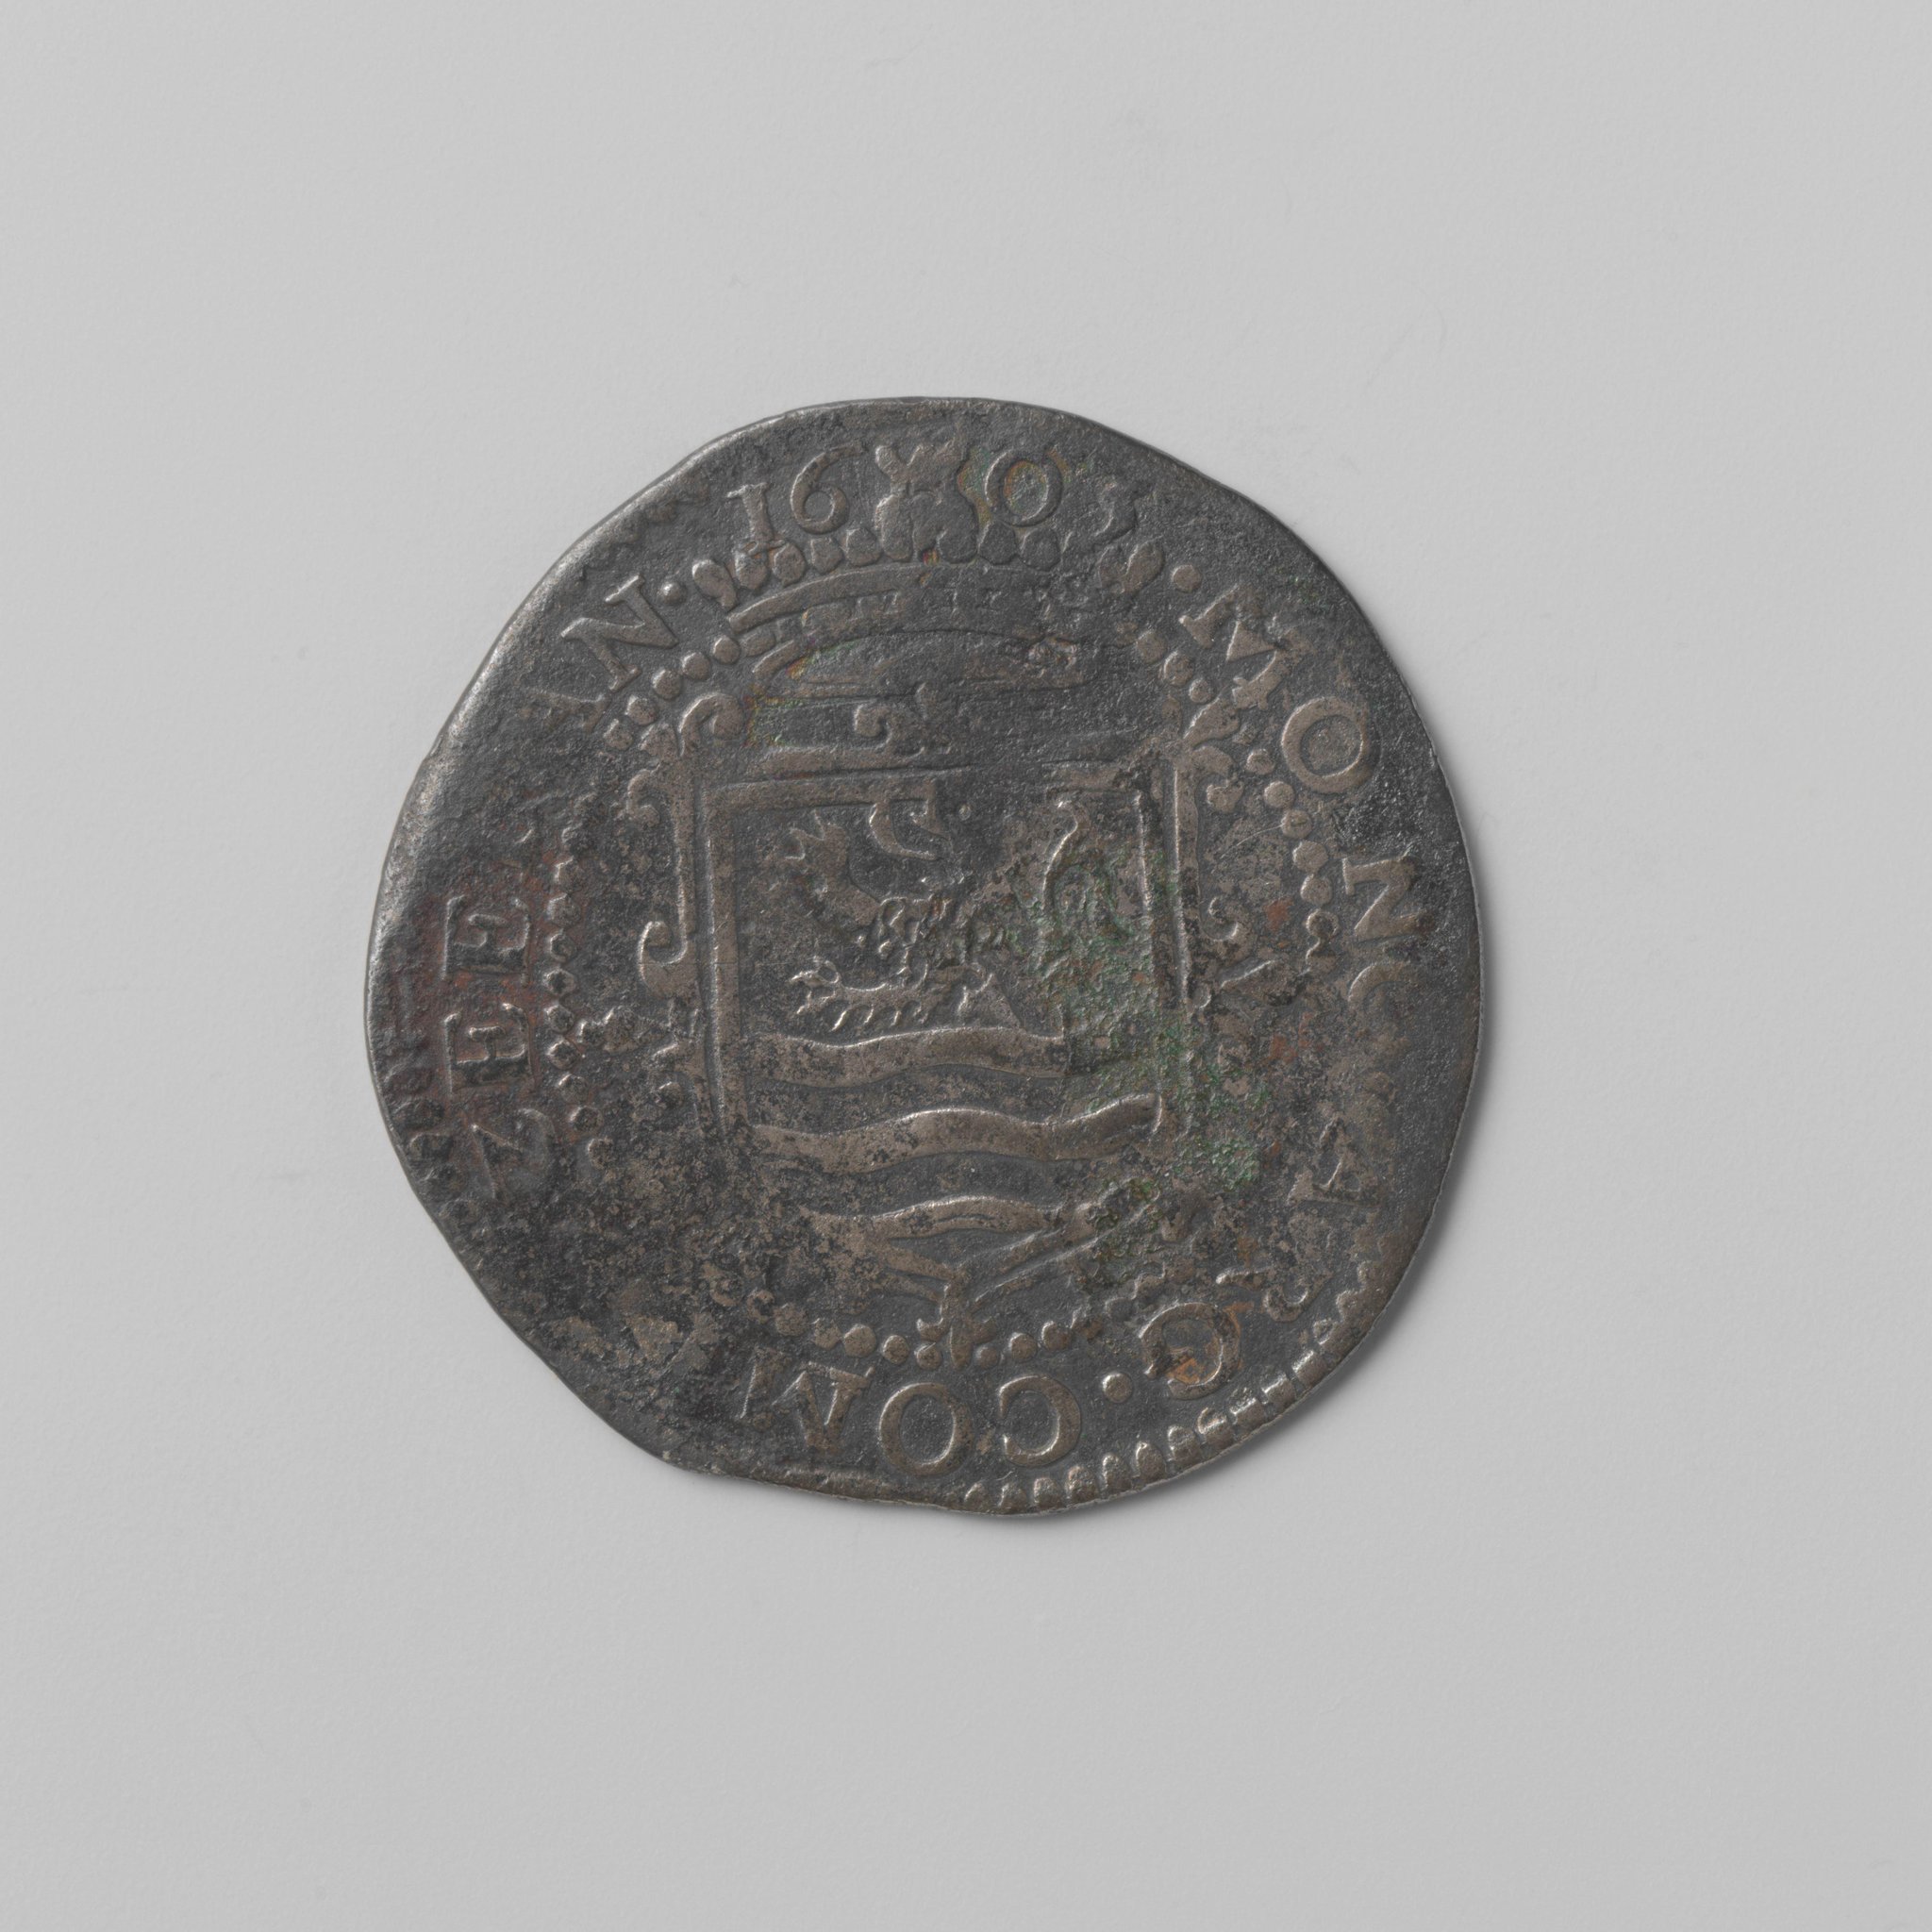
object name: coin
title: Zeeland, roosschelling, 1603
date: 1603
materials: silver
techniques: striking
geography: middelburg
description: Zilveren munt. Voorzijde: gekroond versierd wapenschild van Zeeland. Boven kroon rondom burcht jaartal. Keerzijde: lang versierd kruis met in het hart burcht.